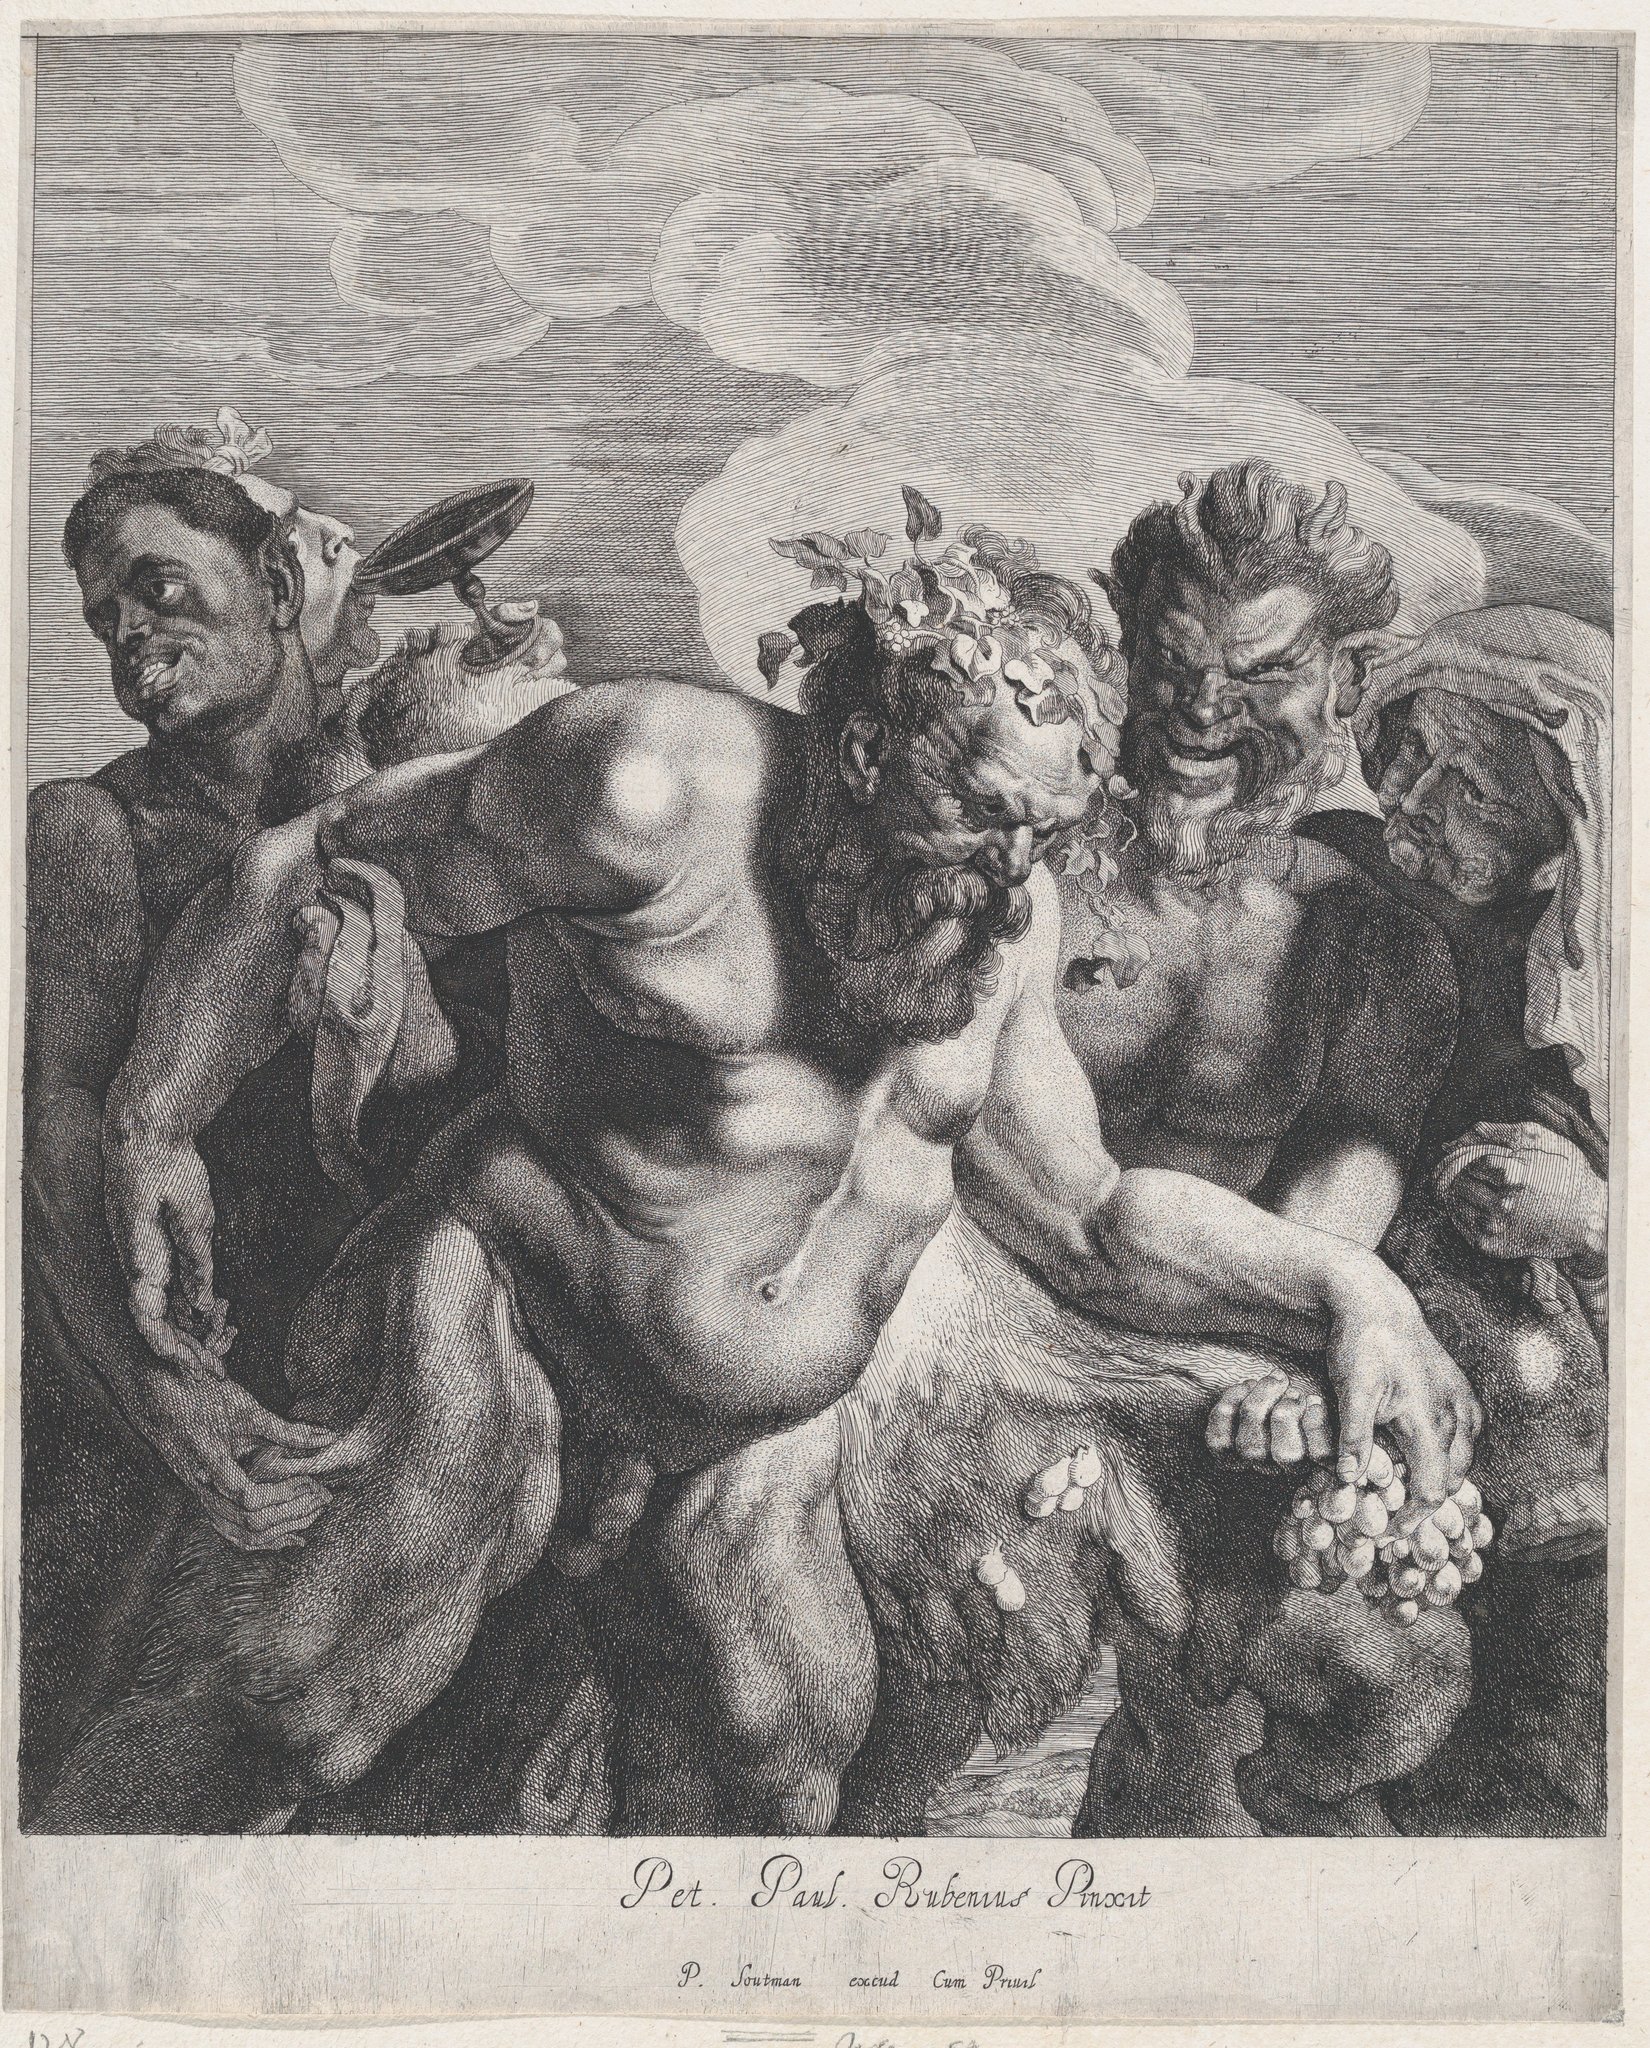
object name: print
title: Drunken Silenus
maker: jonas suyderhoef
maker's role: artist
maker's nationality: dutch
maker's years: 1613-1686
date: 1630-1657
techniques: engraving, etching